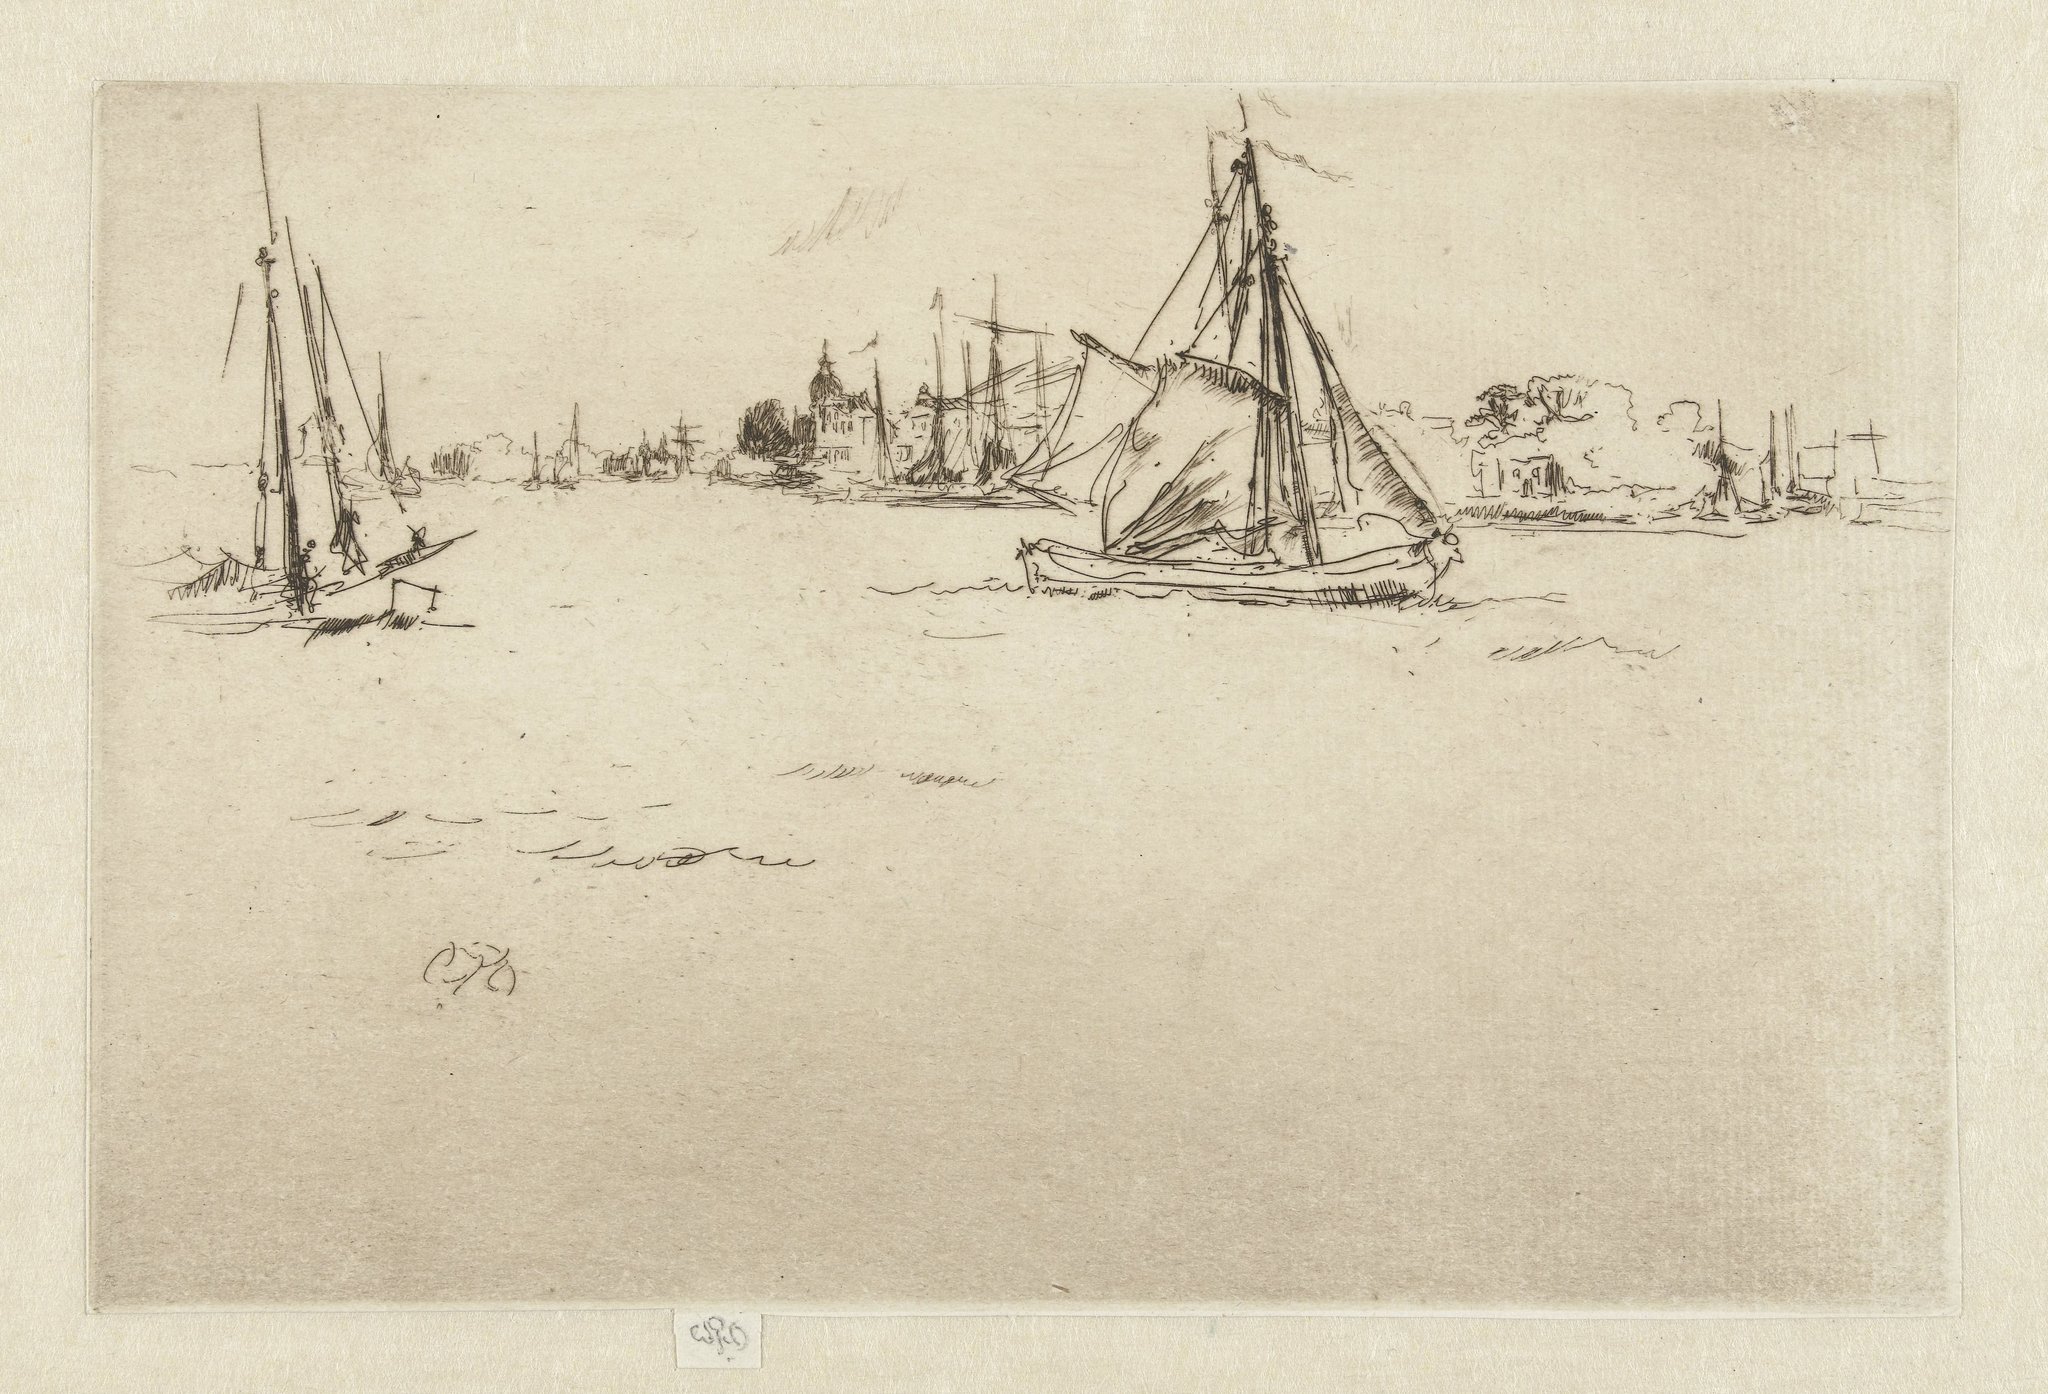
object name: print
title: Gezicht op Dordrecht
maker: james abbott mcneill whistler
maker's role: painter, print maker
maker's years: 1834-1903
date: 1884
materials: paper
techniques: drypoint, etching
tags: prospect of city, town panorama, silhouette of city, dordrecht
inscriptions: collector's mark: Lugt 2760, collector's mark: Lugt 2228, signature: ‘JW’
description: De prent, die in spiegelbeeld het gezicht op de stad laat zien, is waarschijnlijk ter plaatse licht in de plaat getekend.